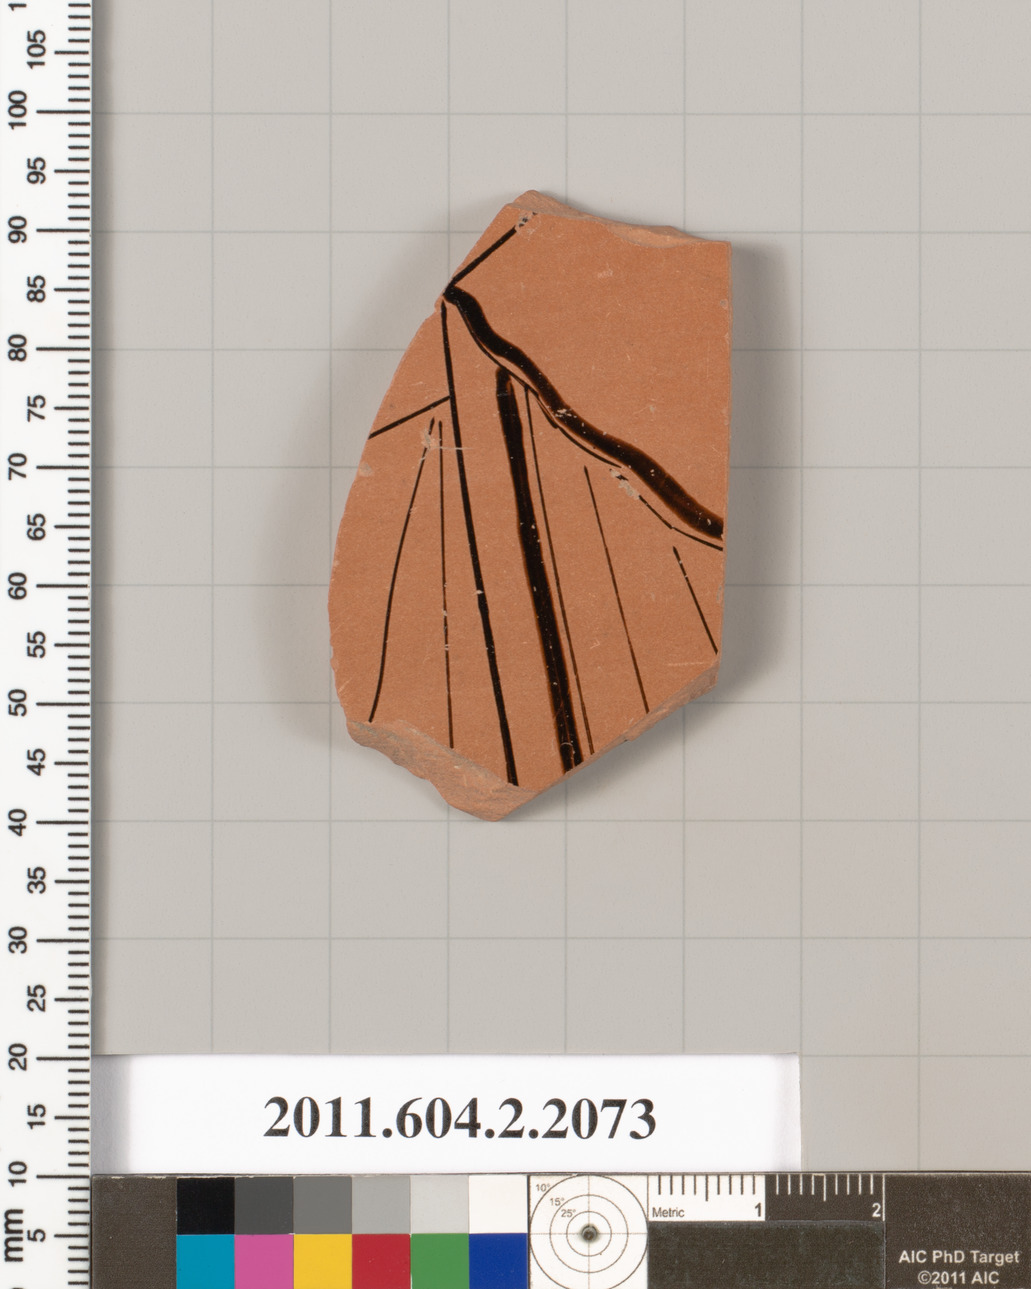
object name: pot fragment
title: Terracotta fragment of a pot; glazed on the inside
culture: greek, attic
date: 460-440 BCE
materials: terracotta